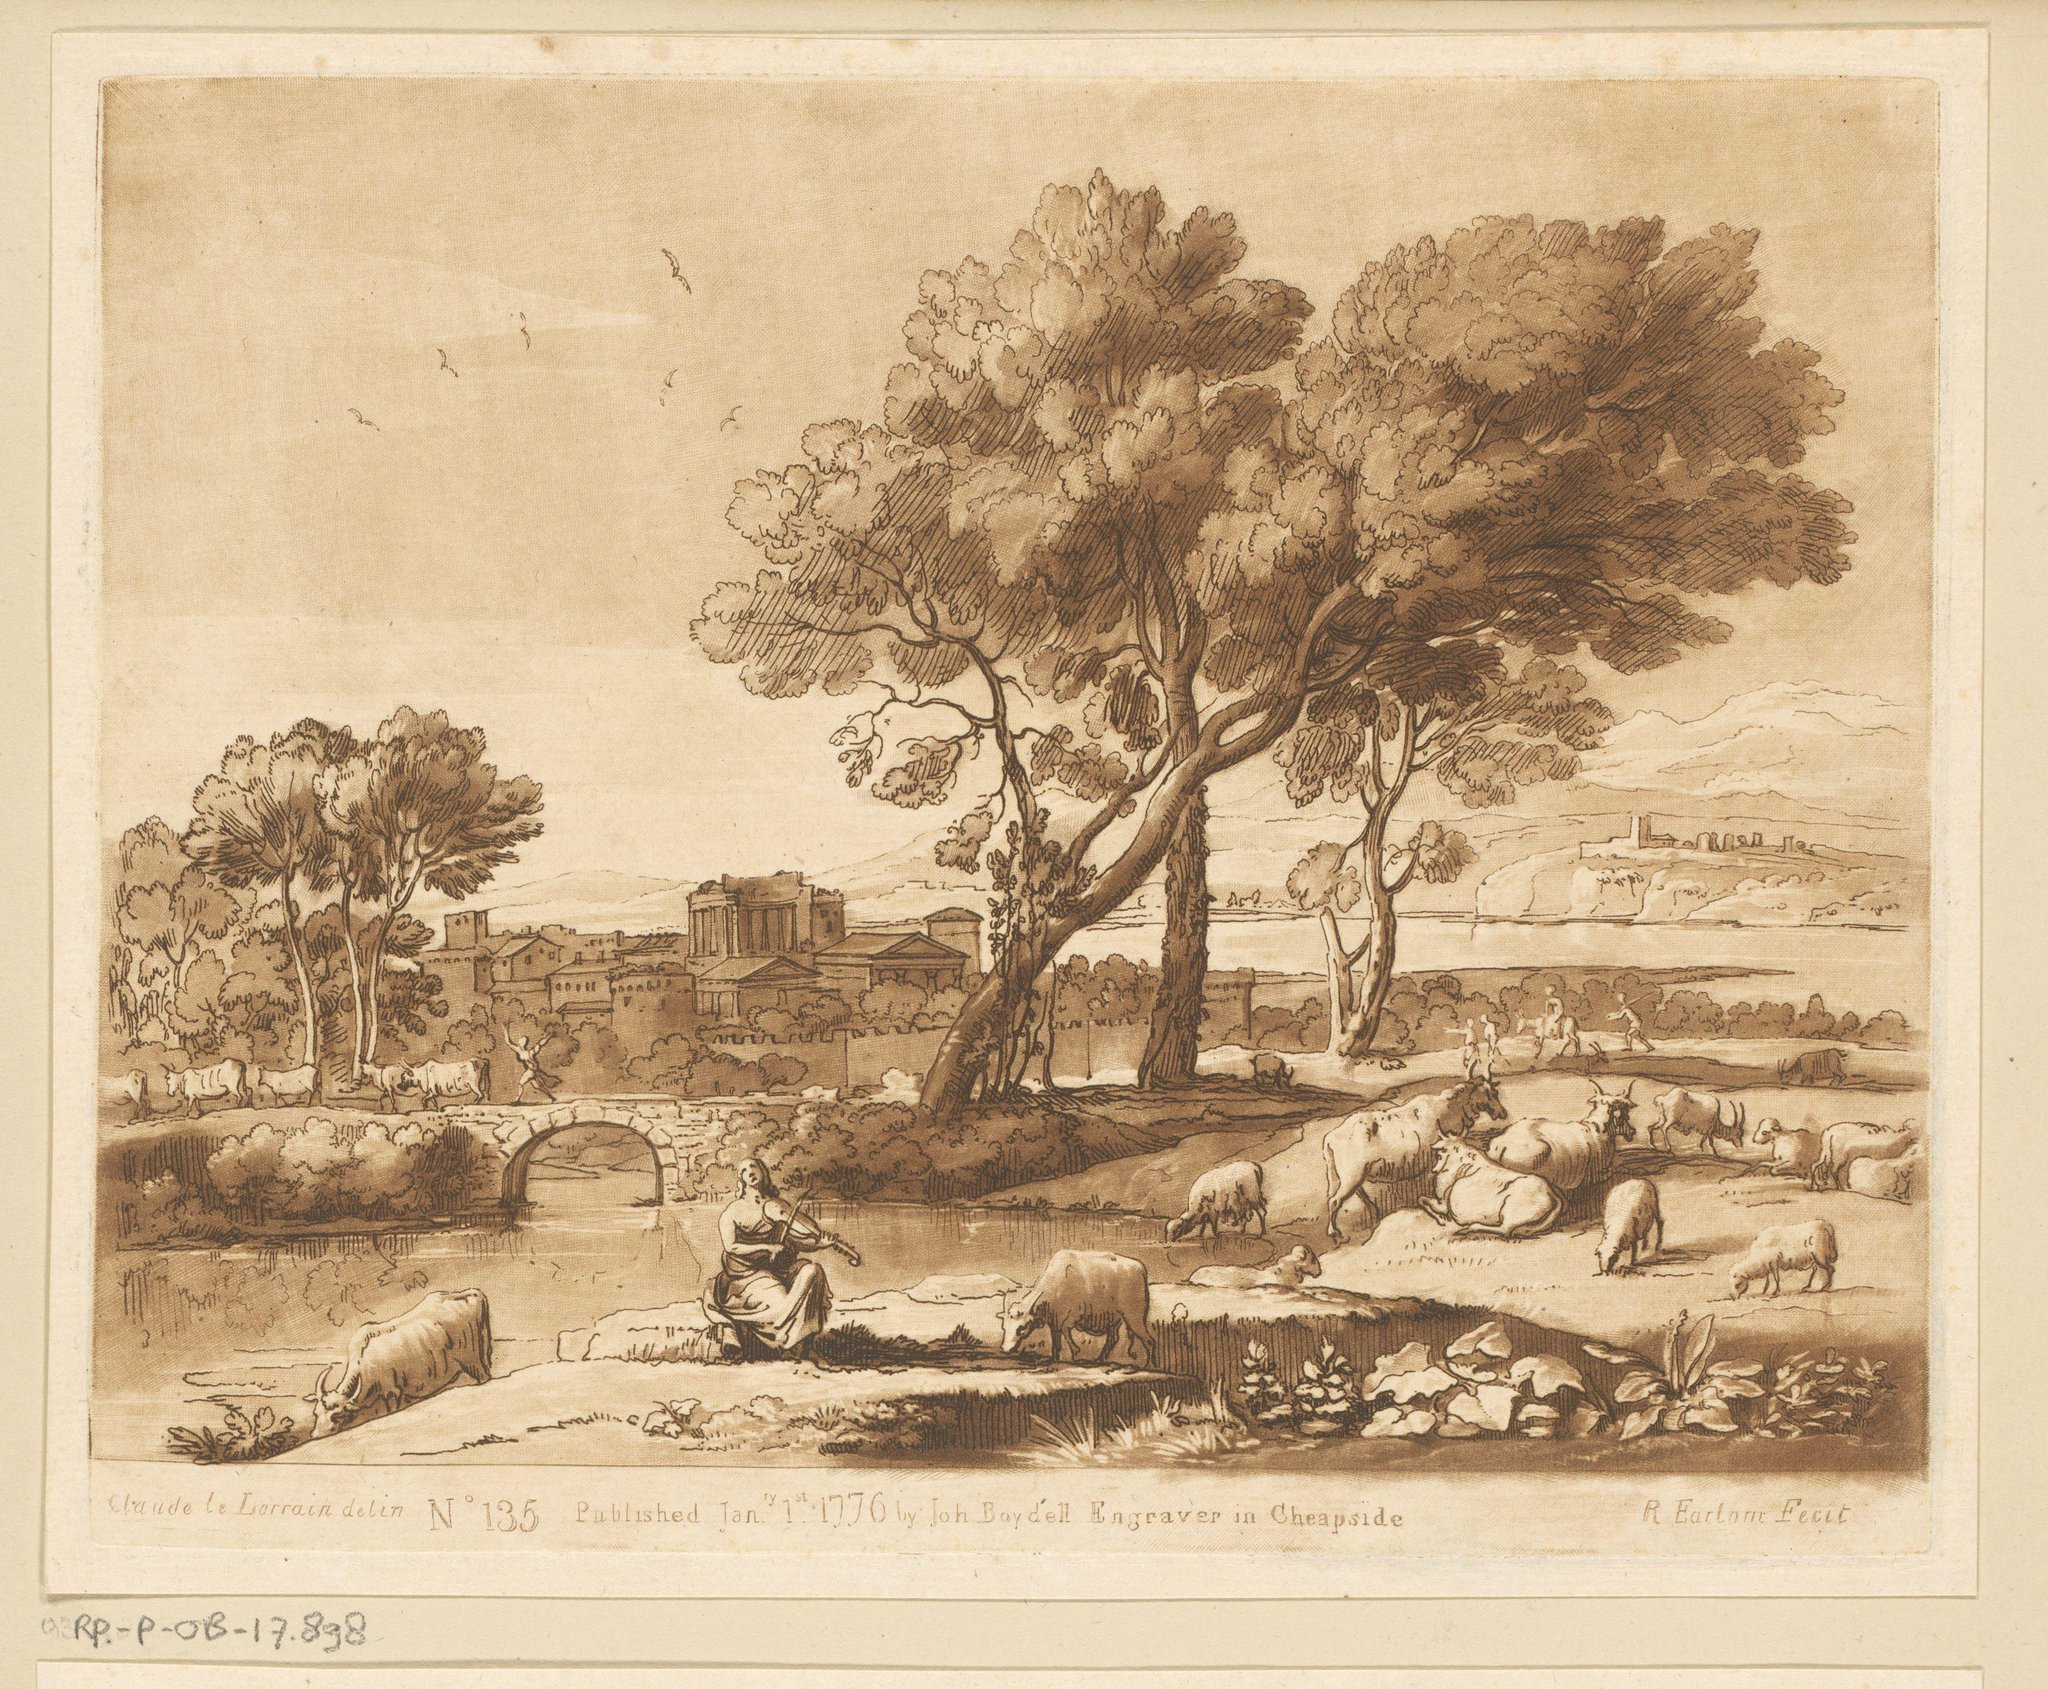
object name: print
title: Prenten naar tekeningen van Claude Lorrain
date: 1776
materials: paper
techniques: etching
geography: london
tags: city-view, and landscape with man-made constructions - ii - ideal landscapes, mercury steals the flock which apollo is tending, landscape with bridge, viaduct or aqueduct - ii - ideal landscapes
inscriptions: date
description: Vanaf 1774 publiceerde John Boydell tweehonderd prenten naar het tekeningenboek Liber Veritatis van Claude Lorrain, in het bezit van de hertogen van Cavendish. Deze prenten werden vanaf 1777 in twee volumes gebundeld uitgegeven.